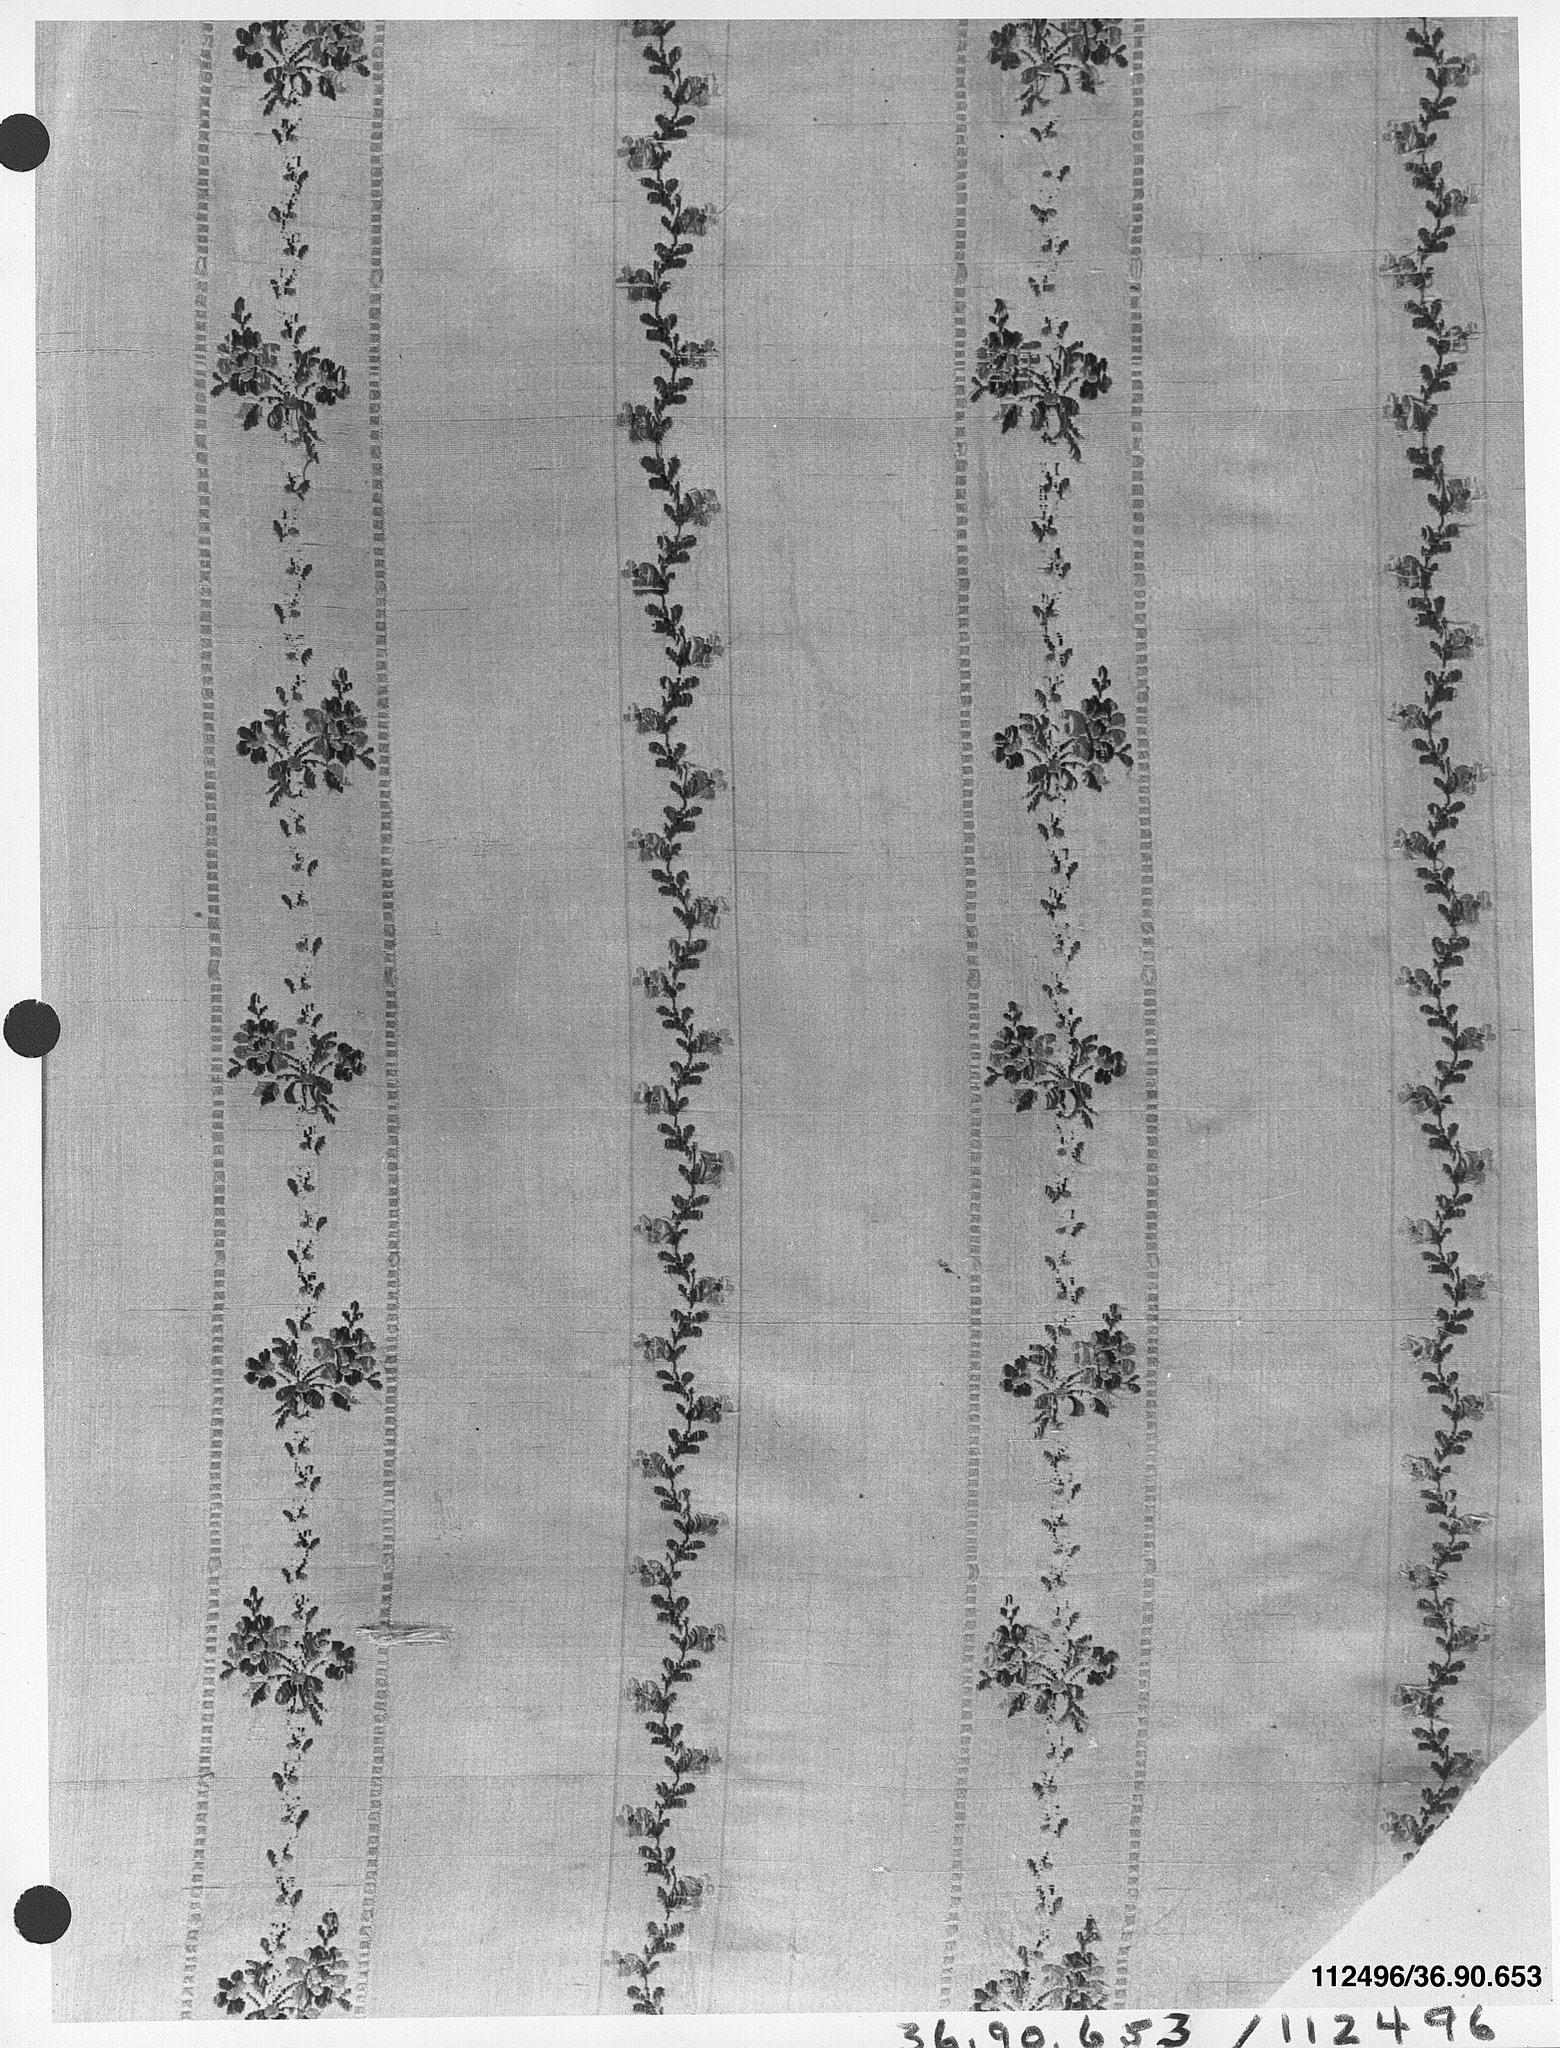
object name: piece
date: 1701-1800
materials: silk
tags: flowers